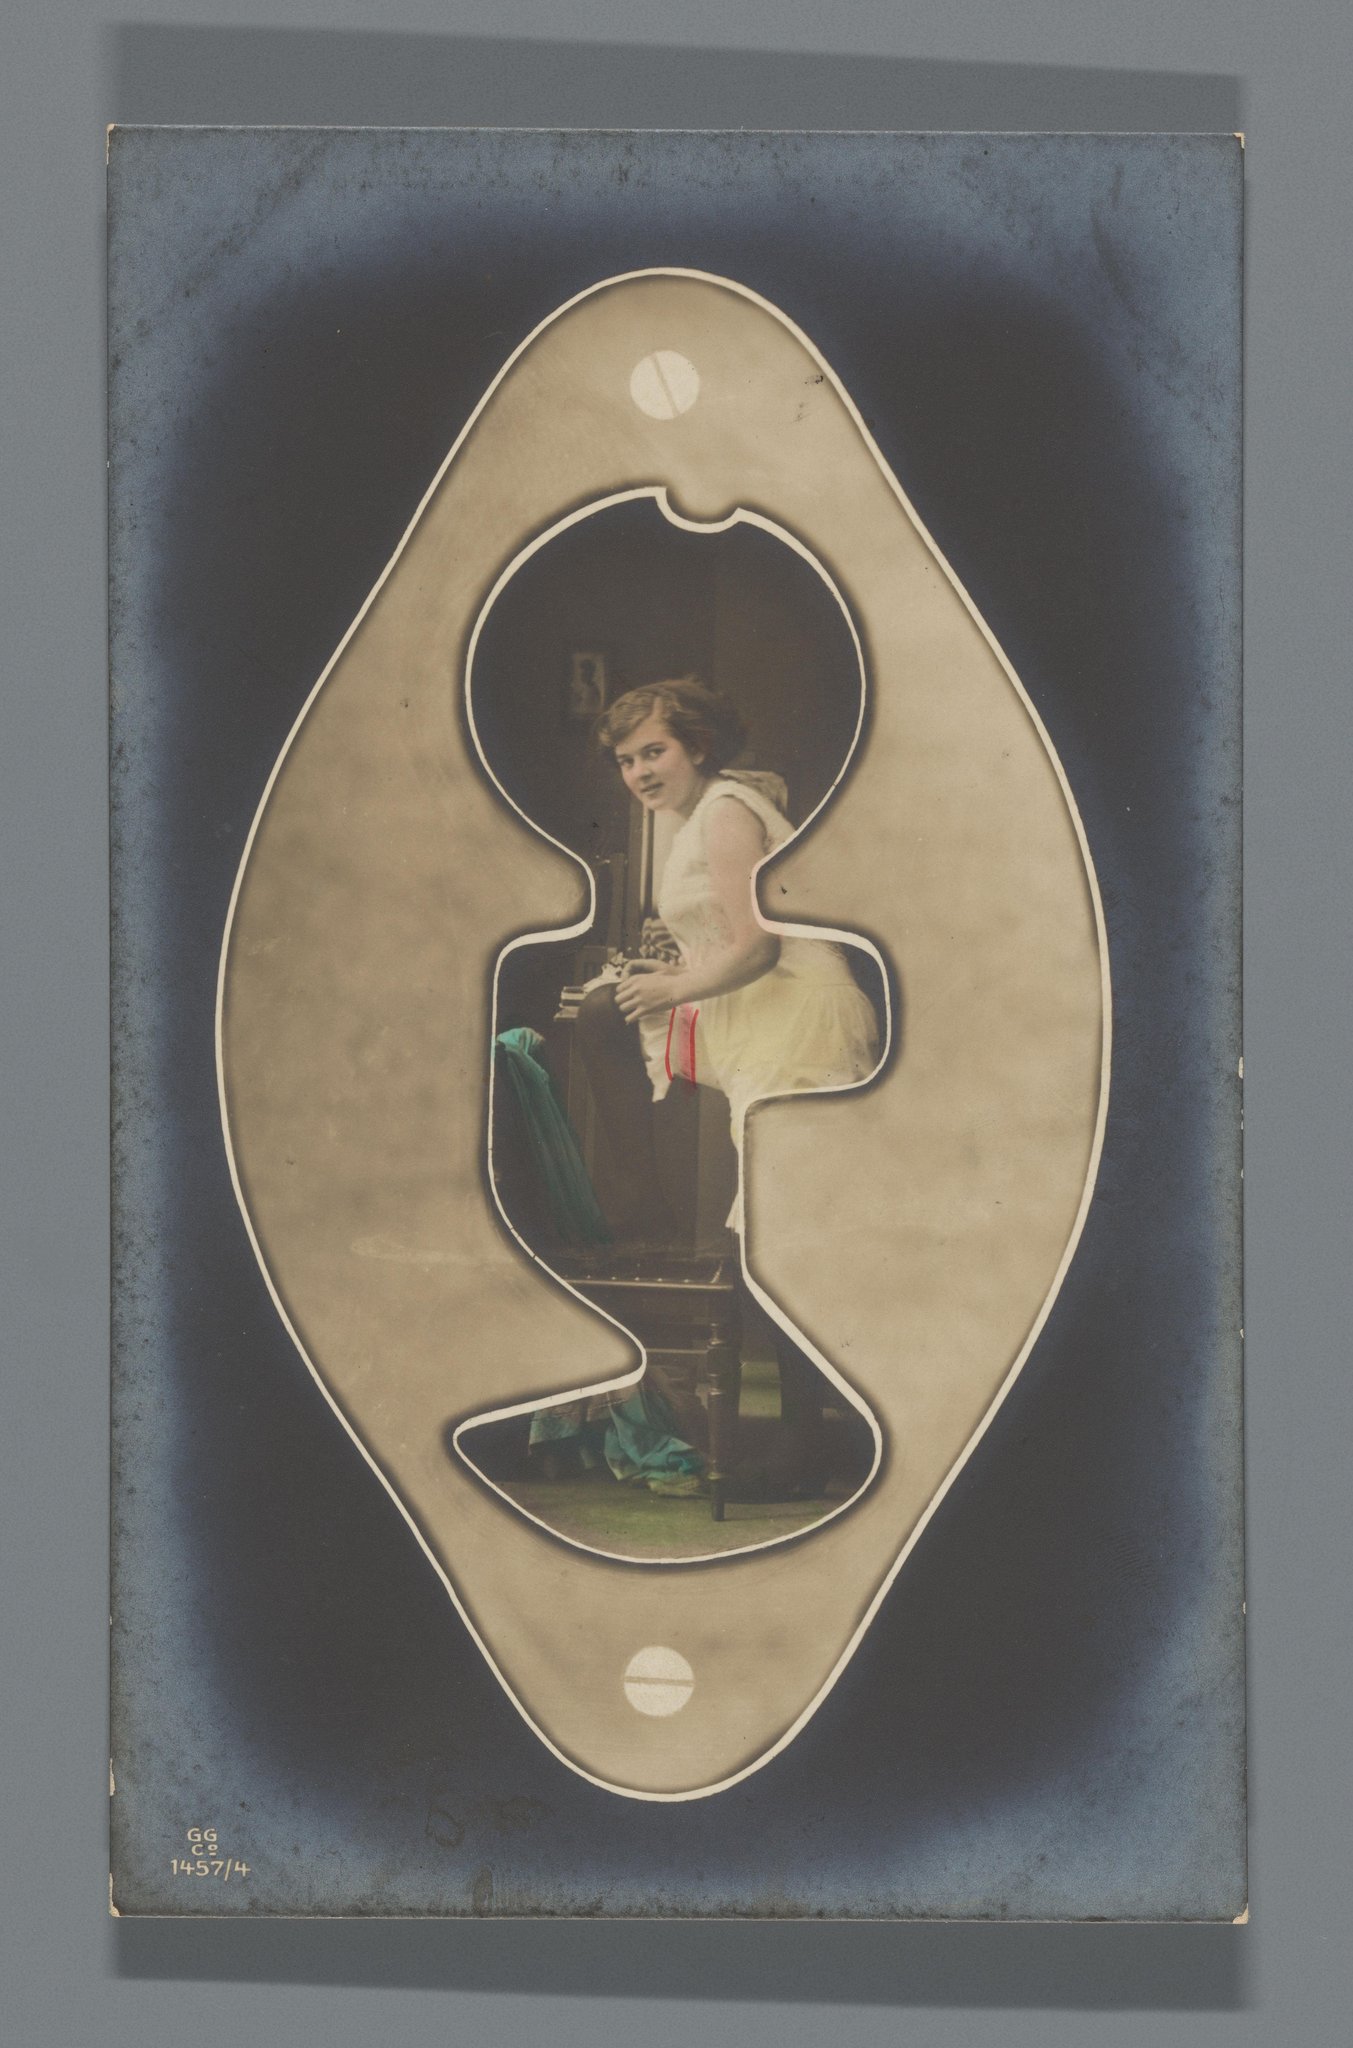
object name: ansichtkaart, prentbriefkaart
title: Vrouw die zich ontkleedt en opmaakt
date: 1920-1930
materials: paper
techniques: gelatin silver print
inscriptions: inscription: ‘P.R.A.’, inscription: ‘GG / Co / 1457/4’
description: Een van zes postkaarten/prentbriefkaarten met een voorstelling van een vrouw die zich ontkleedt en opmaakt, gezien door een sleutelgat.